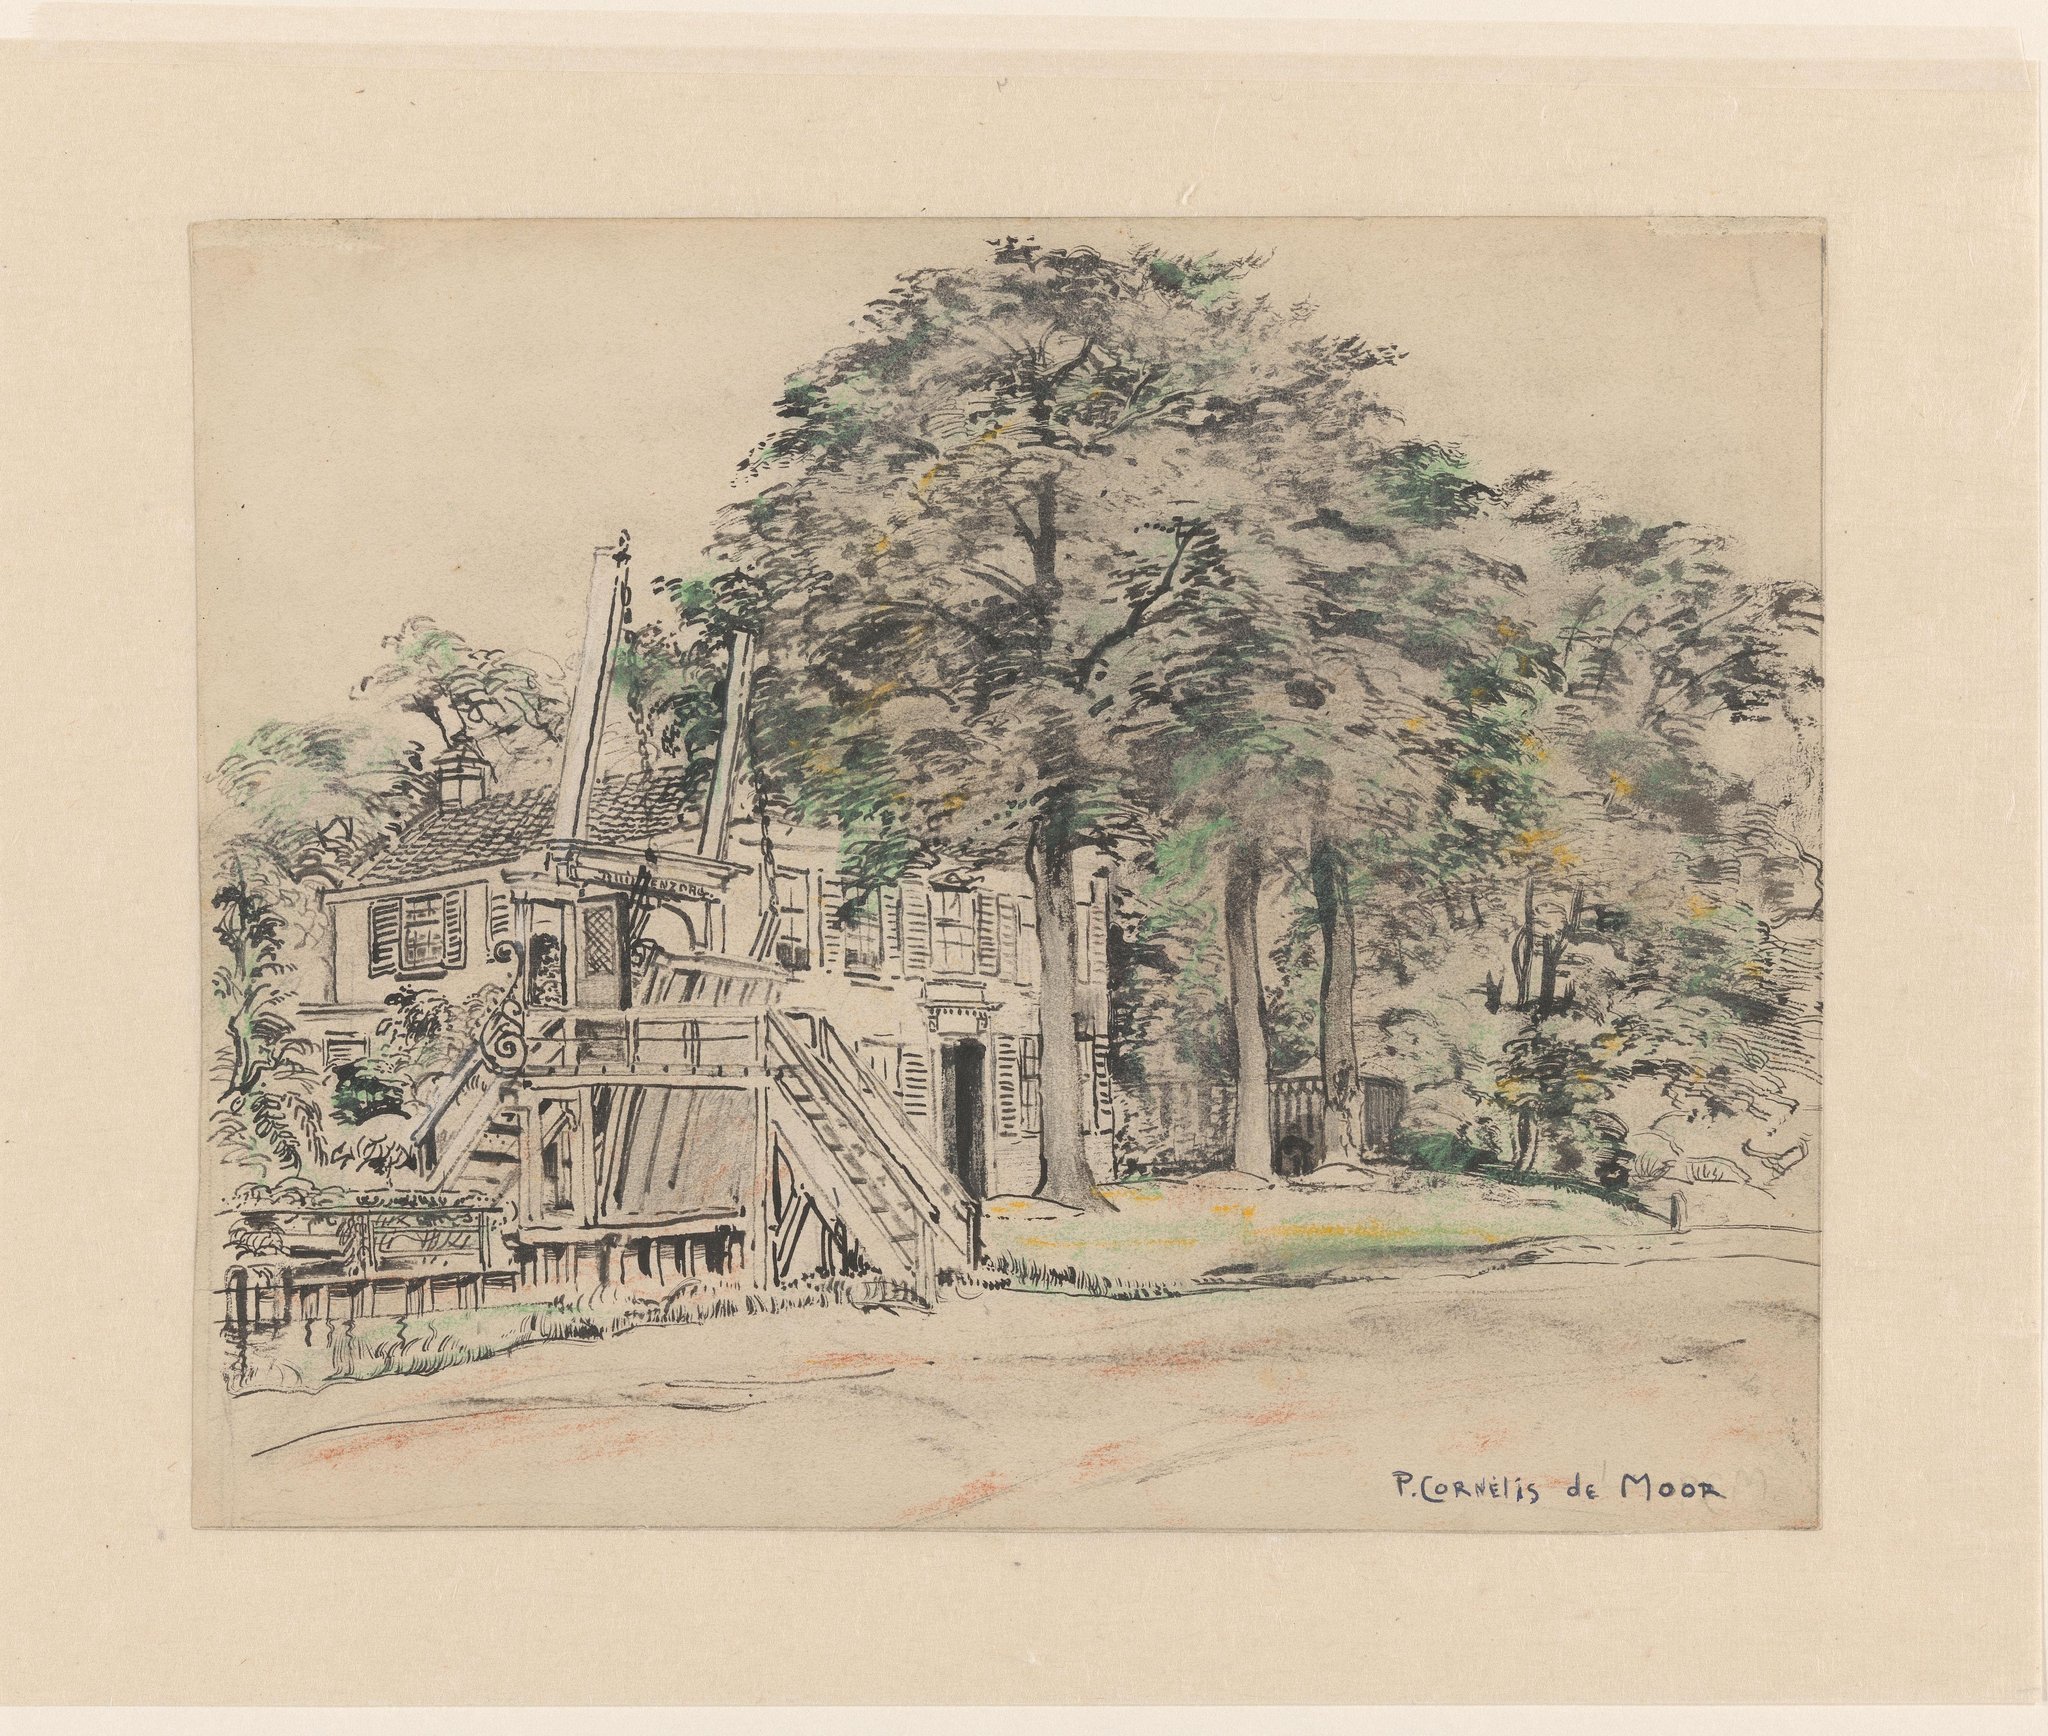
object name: drawing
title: Huis Buitenzorg in de buurt van Rotterdam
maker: pieter cornelis de moor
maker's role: draughtsman, print maker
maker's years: 1866-1953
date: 1876-1953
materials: chalk, ink, paper, pencil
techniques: pen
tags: castle, rural housing, e.g. country-house, villa, cottage, rotterdam